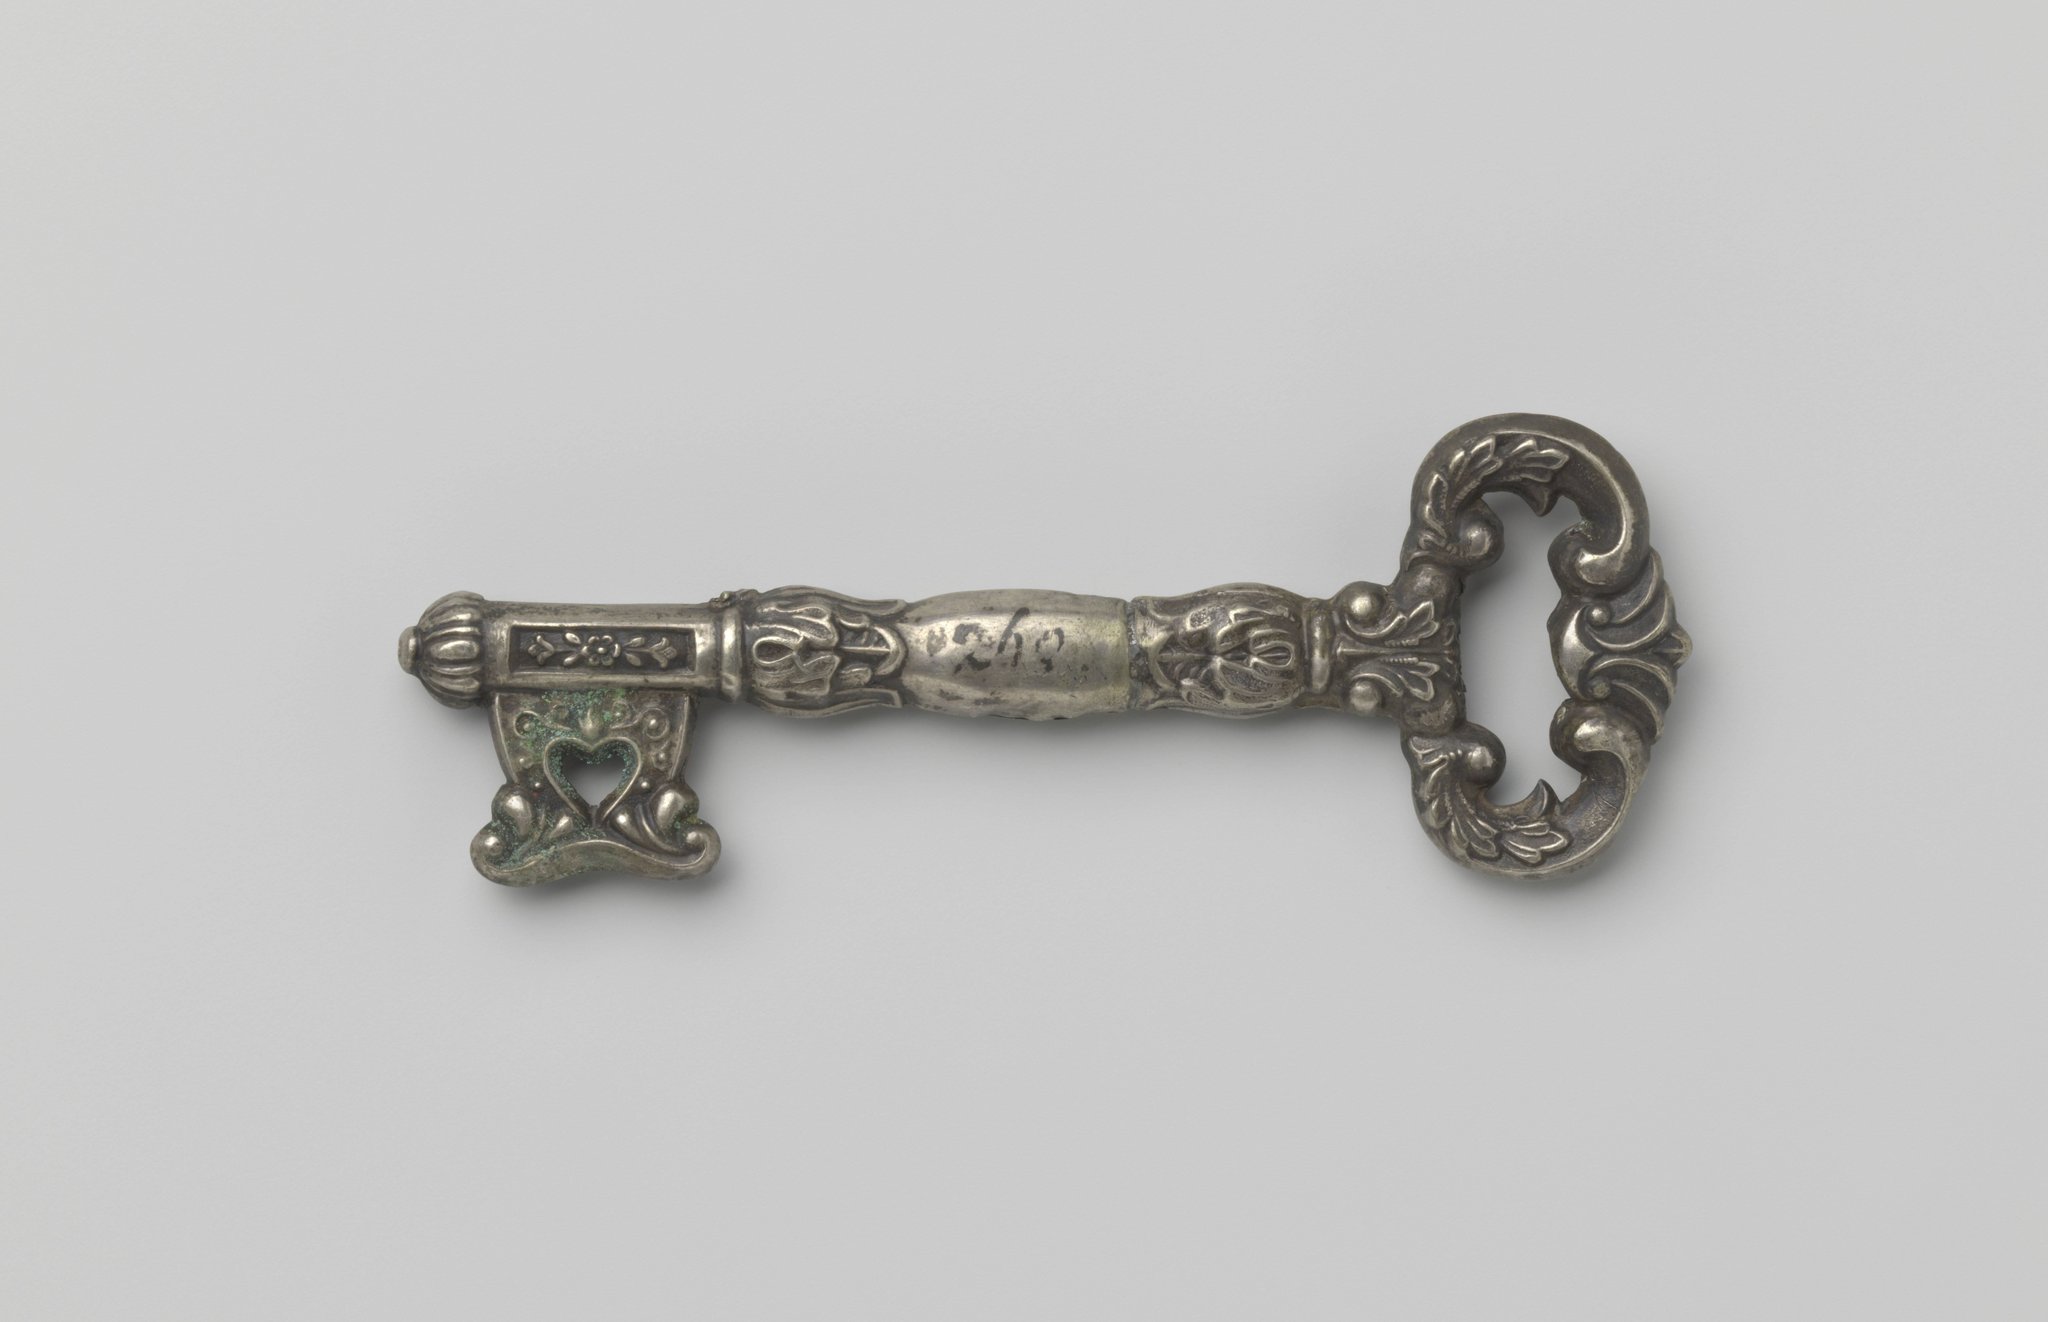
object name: siersleutel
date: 1800-1900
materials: silver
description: Bewerkte siersleutel waavan het oog bestaat uit twee naar elkaar toegewendt, met bladranken versierde C-voluten. De schacht onder het oog en boven de baard is omgeven met acanthusblad; zij eindigt in een geprofileerd knopje. De baard heeft een hartvormige opening.